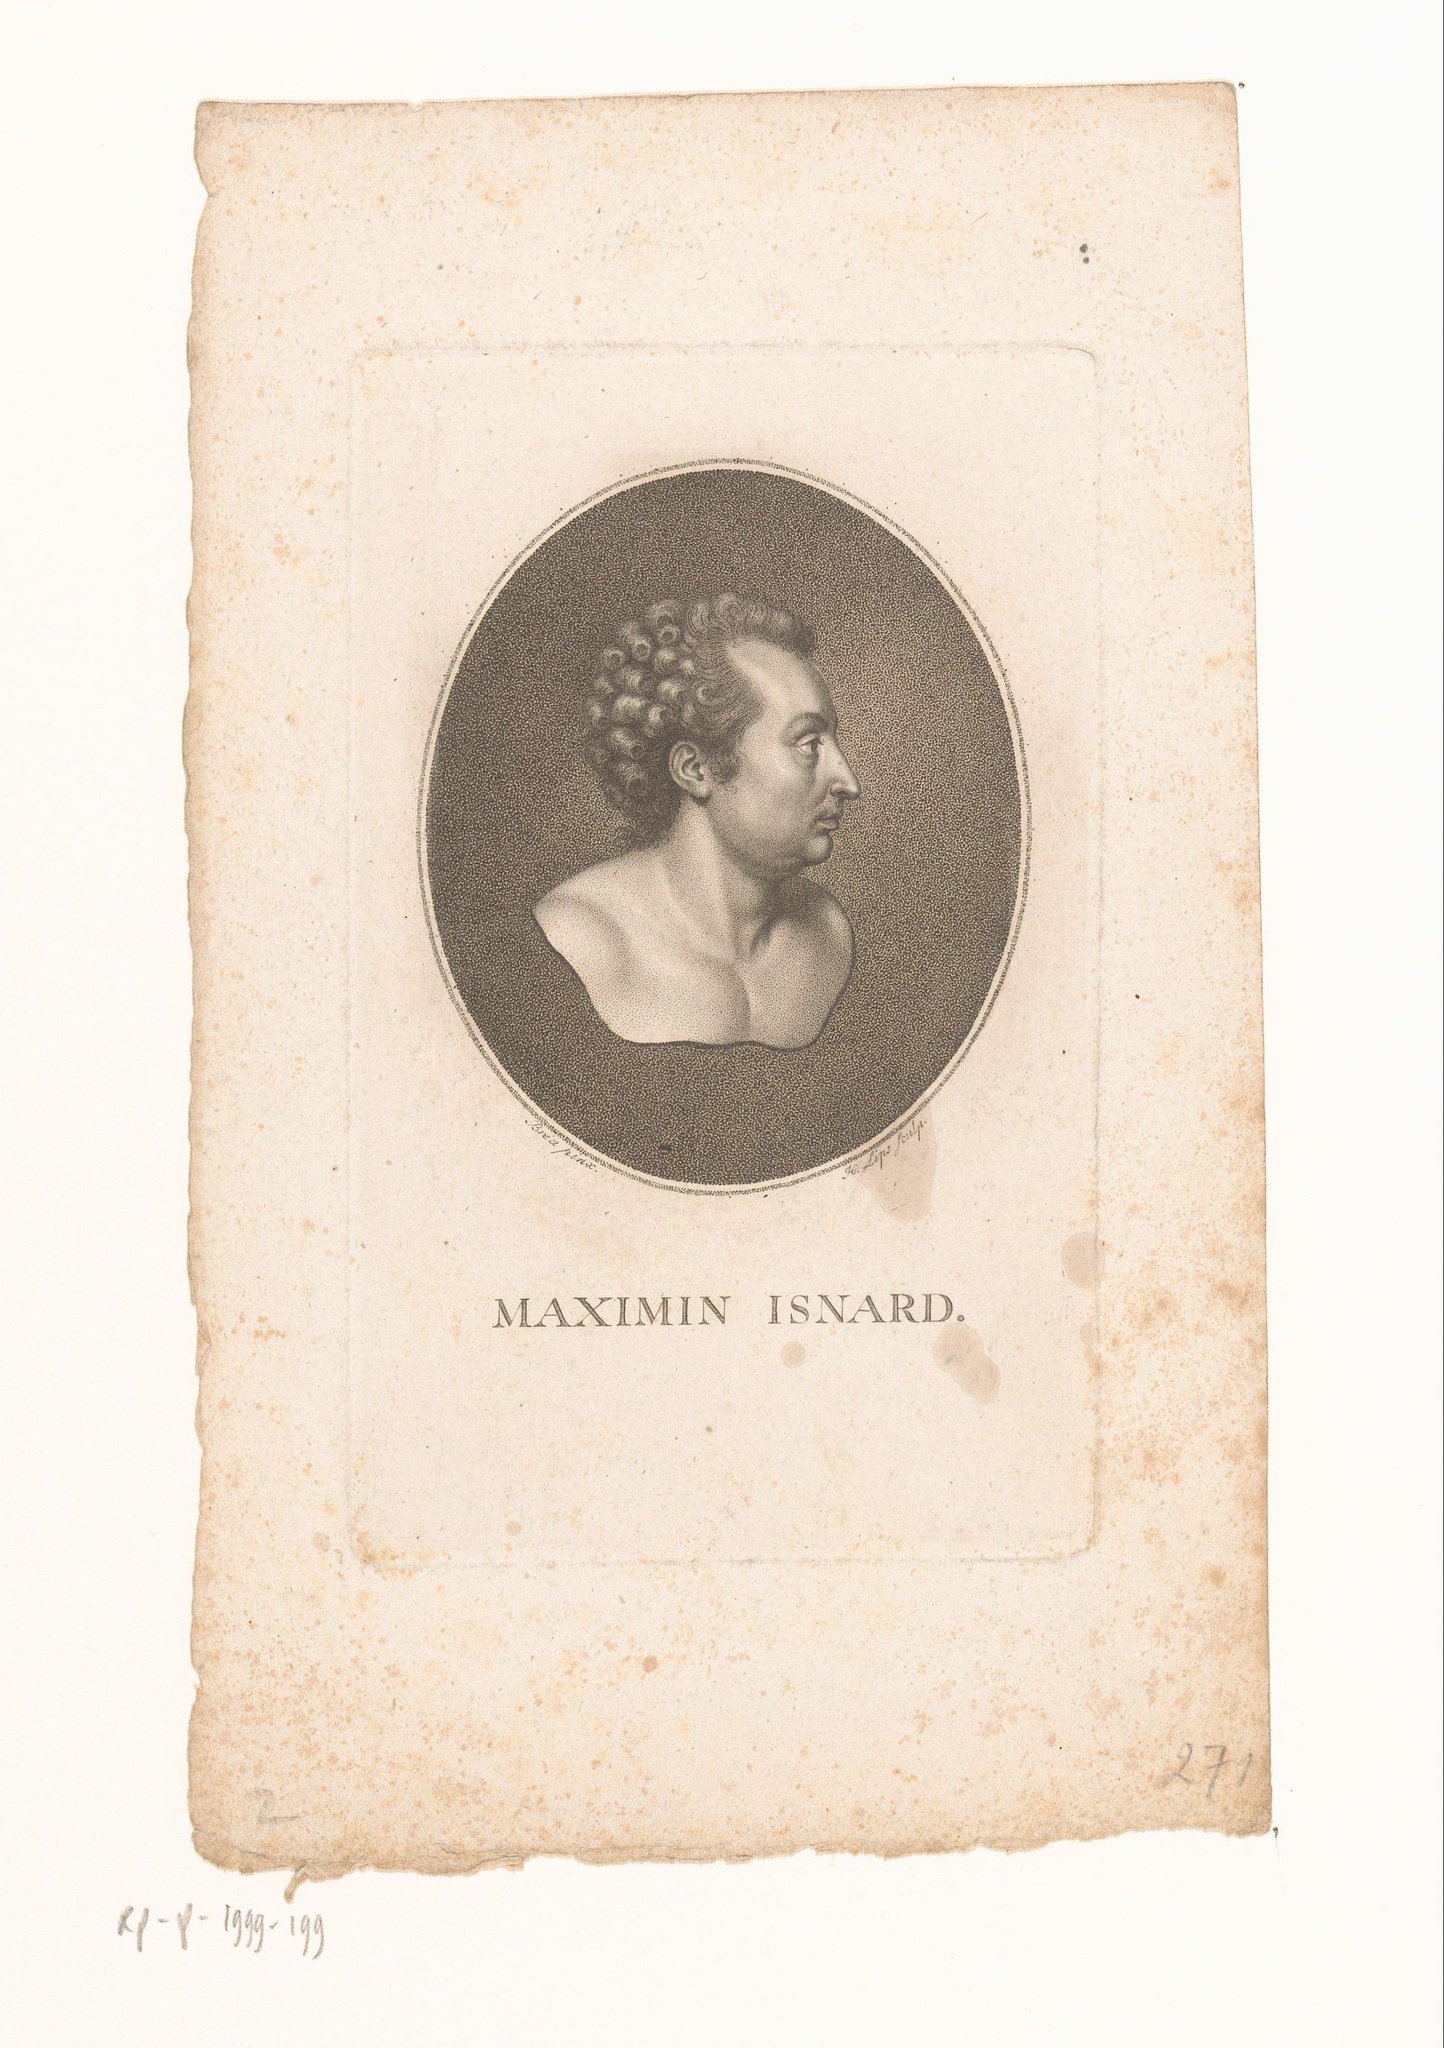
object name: print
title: Portret van Maximin Isnard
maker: johann heinrich lips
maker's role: draughtsman, painter, print maker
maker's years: 1758-1817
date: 1768-1817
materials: paper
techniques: stippling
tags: historical persons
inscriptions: collector's mark: Lugt 2228, collector's mark: Lugt 2760